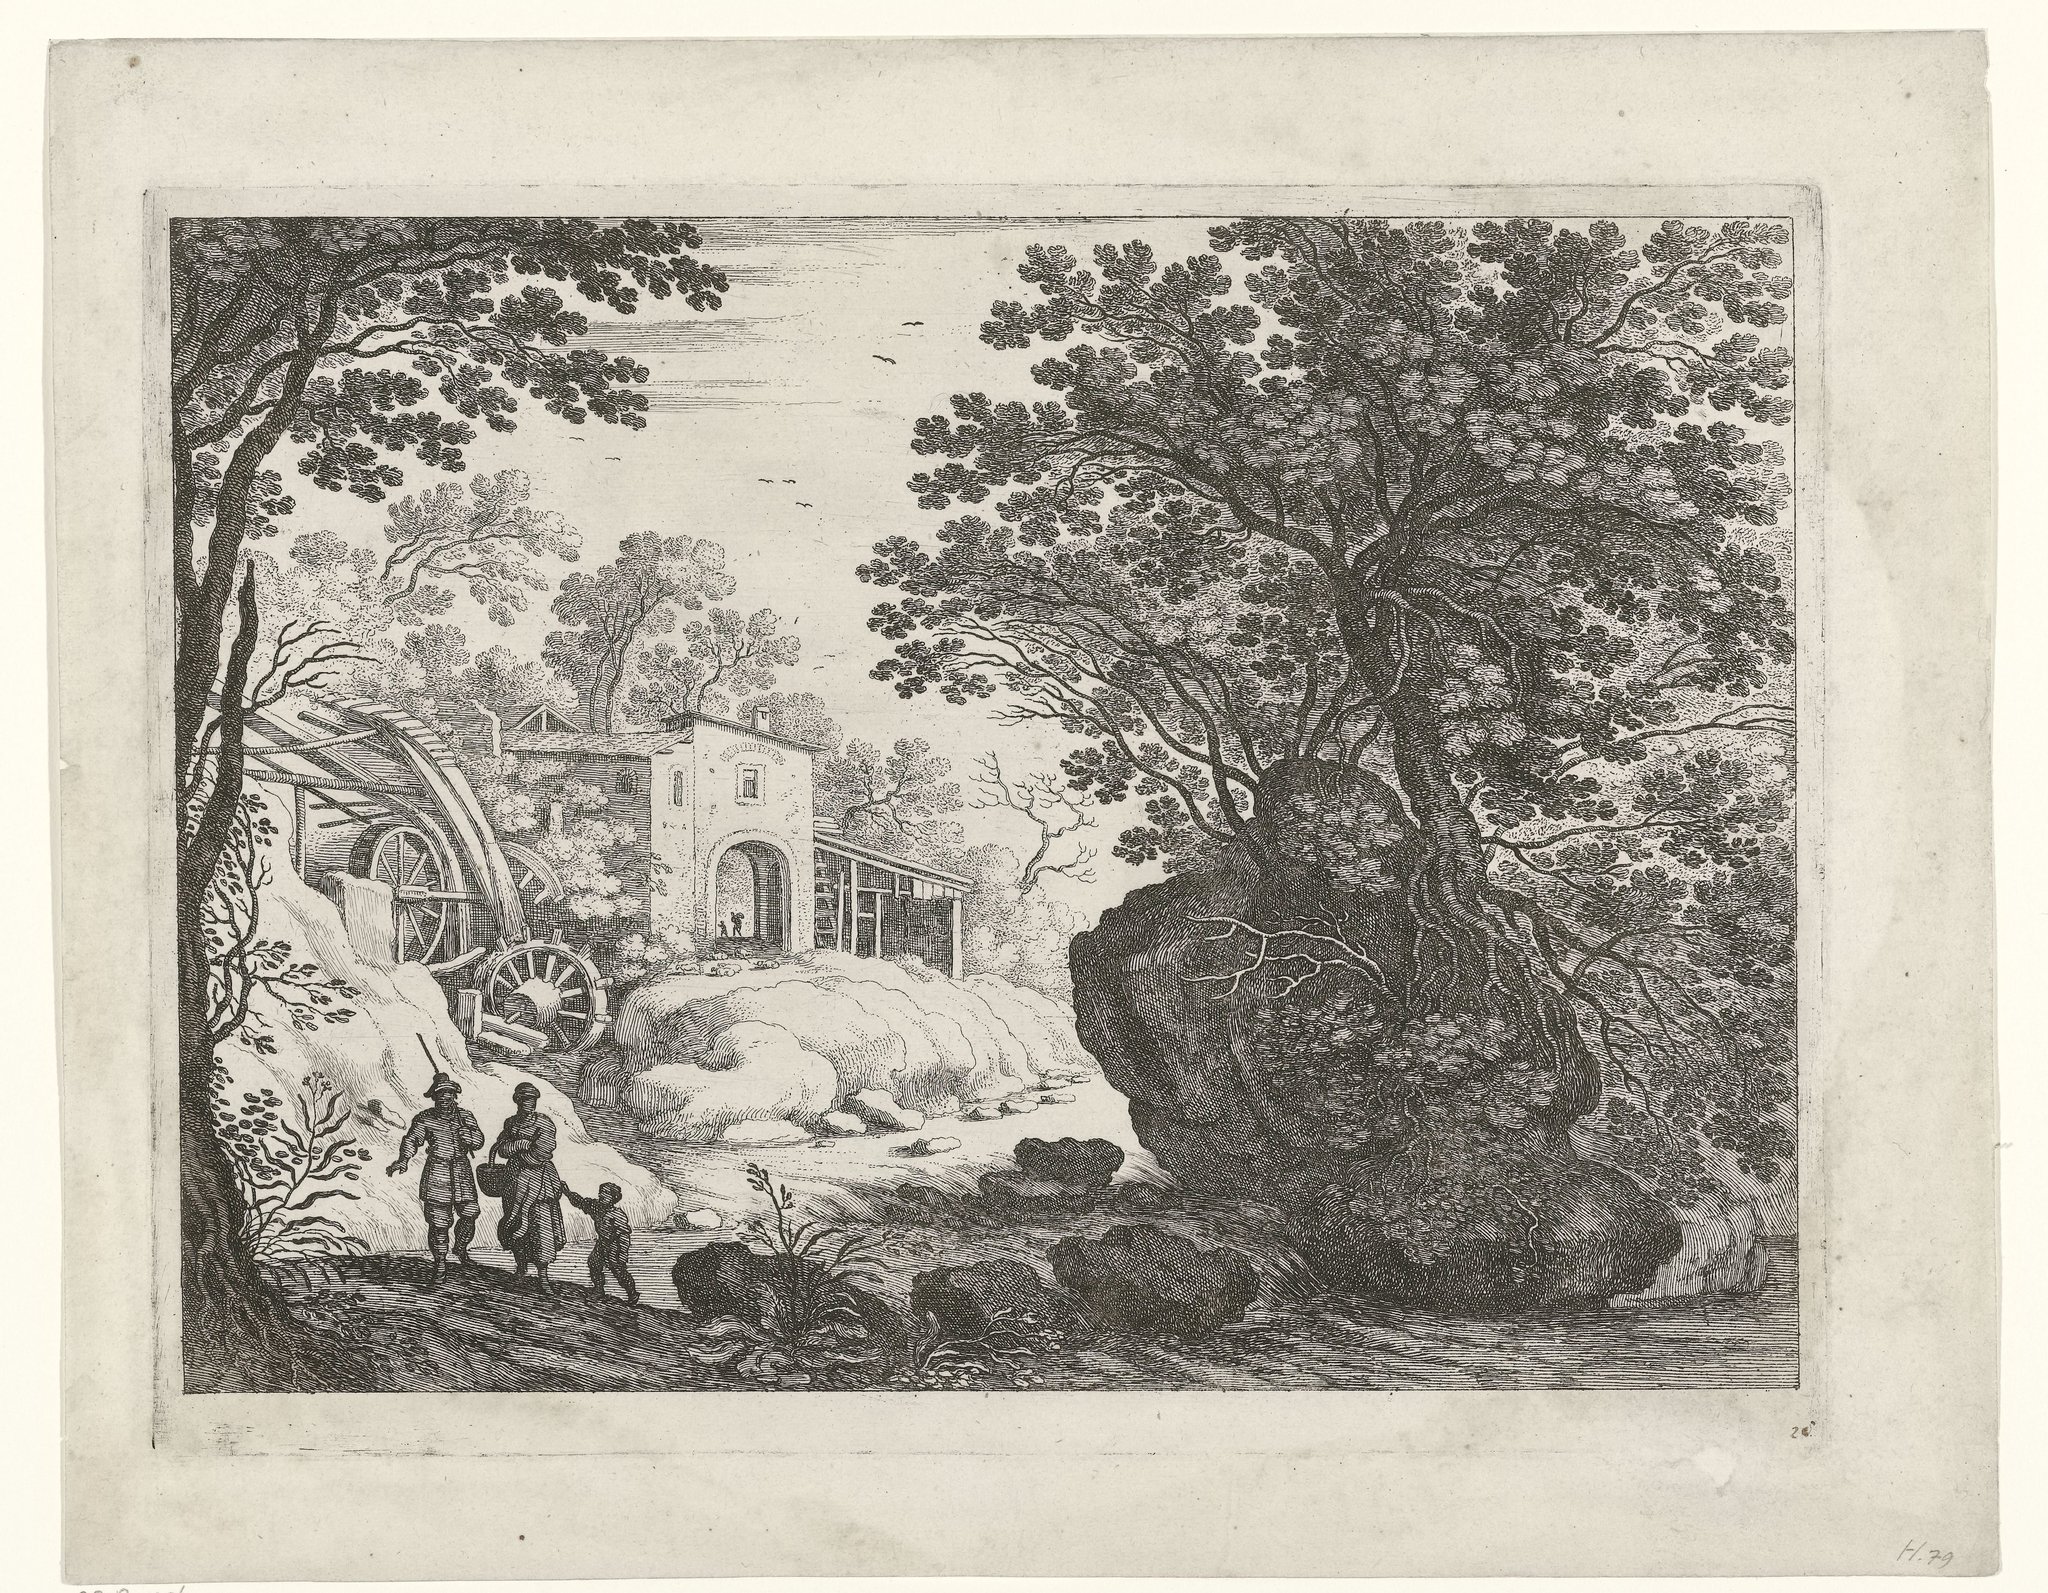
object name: print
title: Watermolen aan landweg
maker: guilliam van nieulandt (ii)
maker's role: draughtsman, print maker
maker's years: 1584-1635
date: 1594-1635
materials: paper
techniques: engraving, etching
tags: watermill, watermill in landscape, rocks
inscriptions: collector's mark: Lugt 2760, collector's mark: Lugt 2228, number: ‘28’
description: Bij een beekje, met op de achtergrond een watermolen, lopen een man, een vrouw met een mand aan haar arm en een kind. Rechts bomen op een grote rots. Prent uit een serie Italiaanse landschappen.